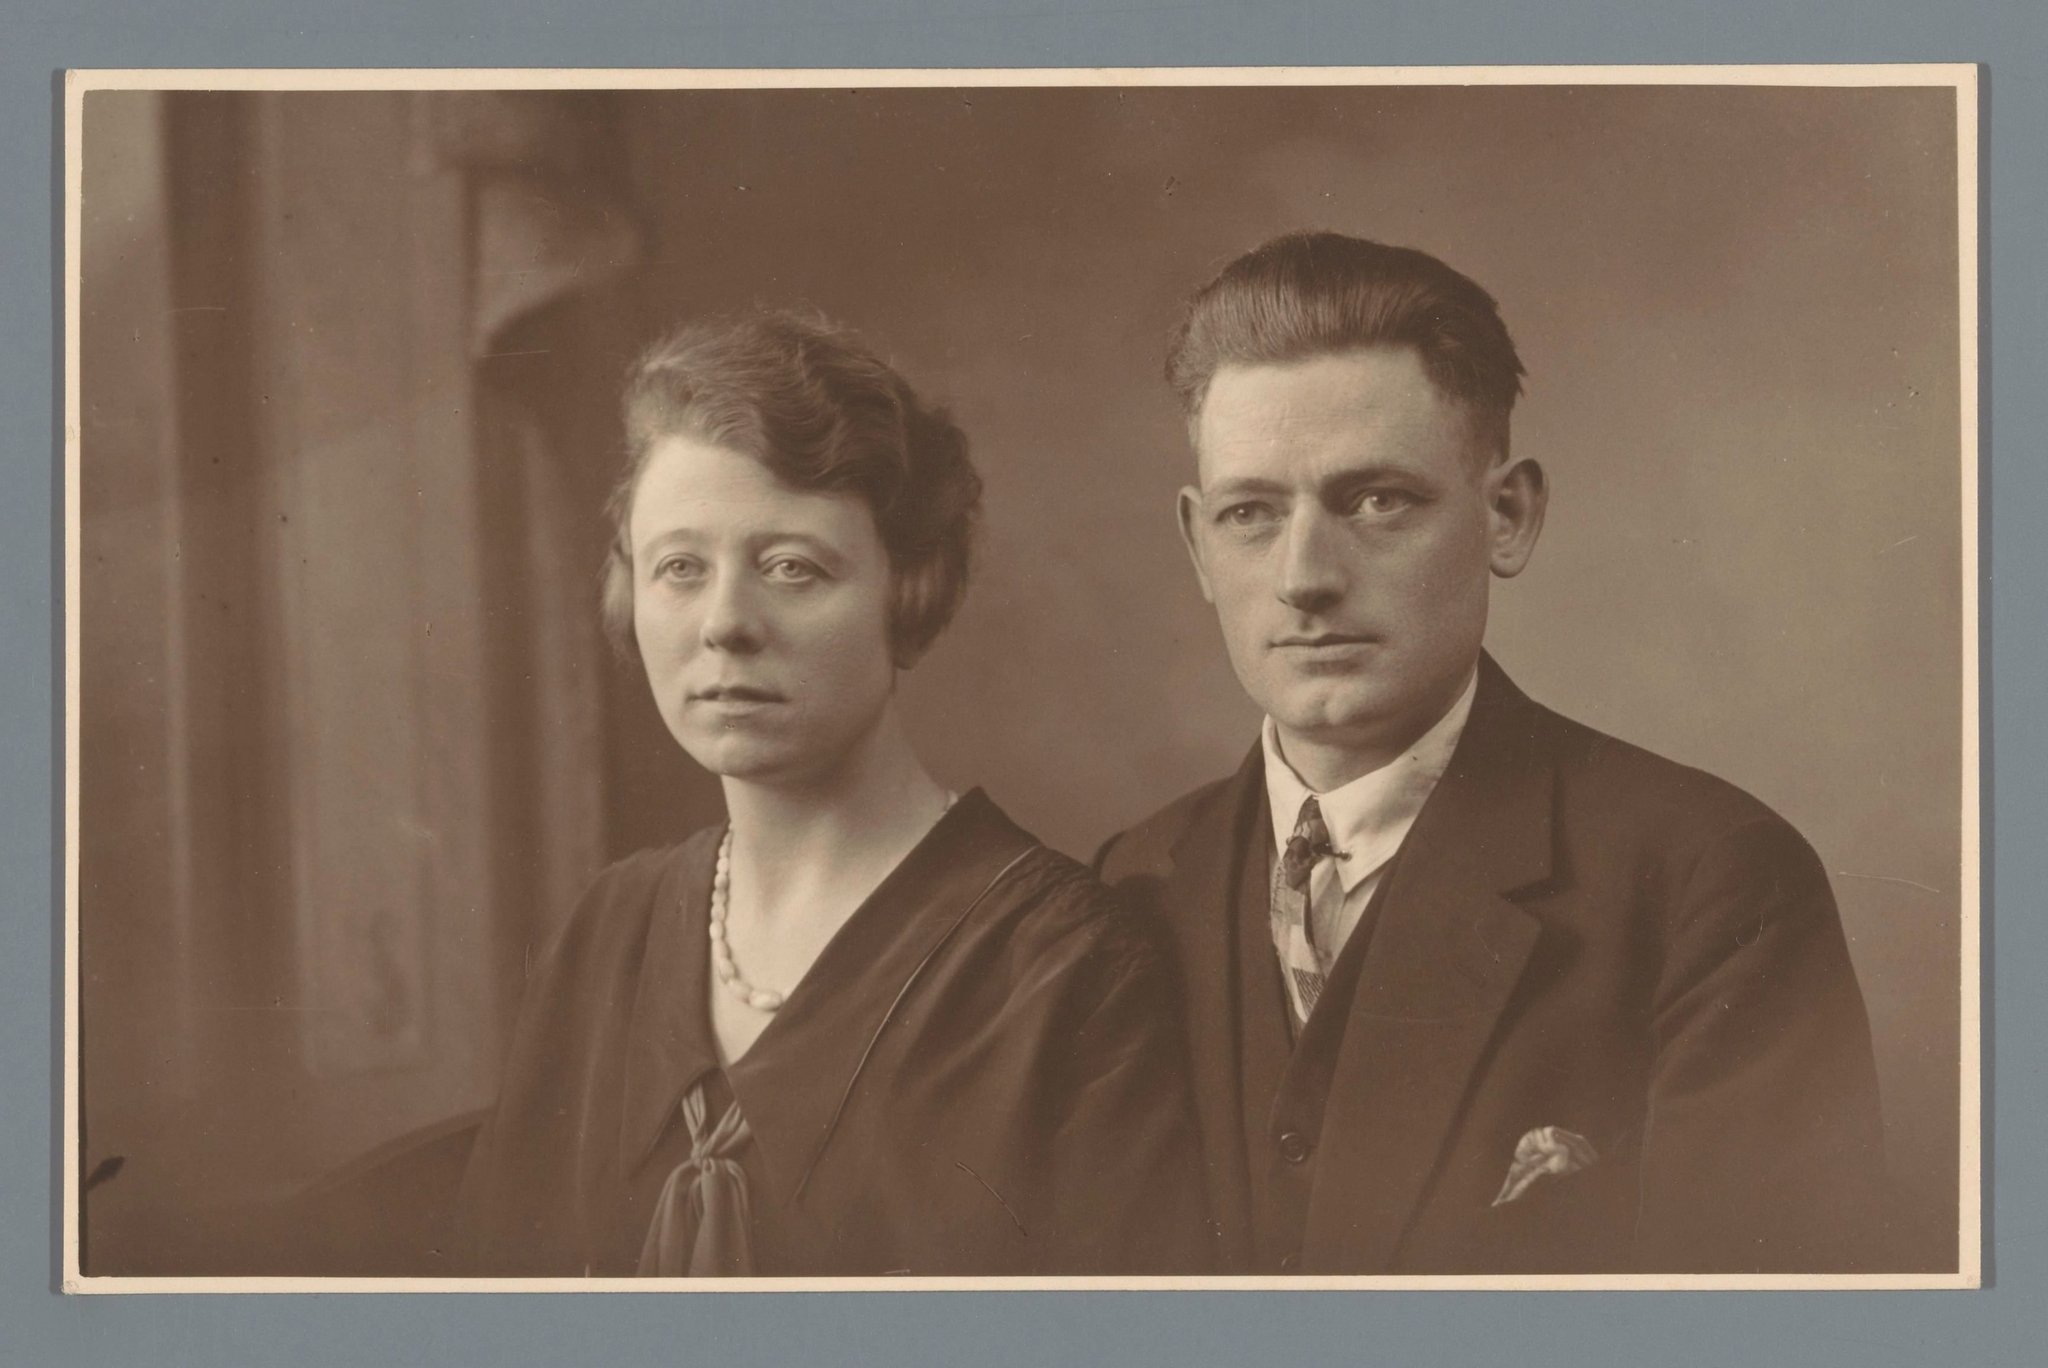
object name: photograph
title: Studioportret van een onbekende man en vrouw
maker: a.m. van der meulen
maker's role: fotograaf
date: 1915-1930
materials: photographic support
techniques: gelatin silver print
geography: amsterdam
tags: marriage, married couple, 'matrimonium'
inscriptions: inscription: ‘A. M. v/d Meulen, fa L. v. Groningen Kinkerstraat , 11 b/d Nassaukade, Amsterdam.’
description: RP-F-F20763 is een ander exemplaar van dezelfde foto.